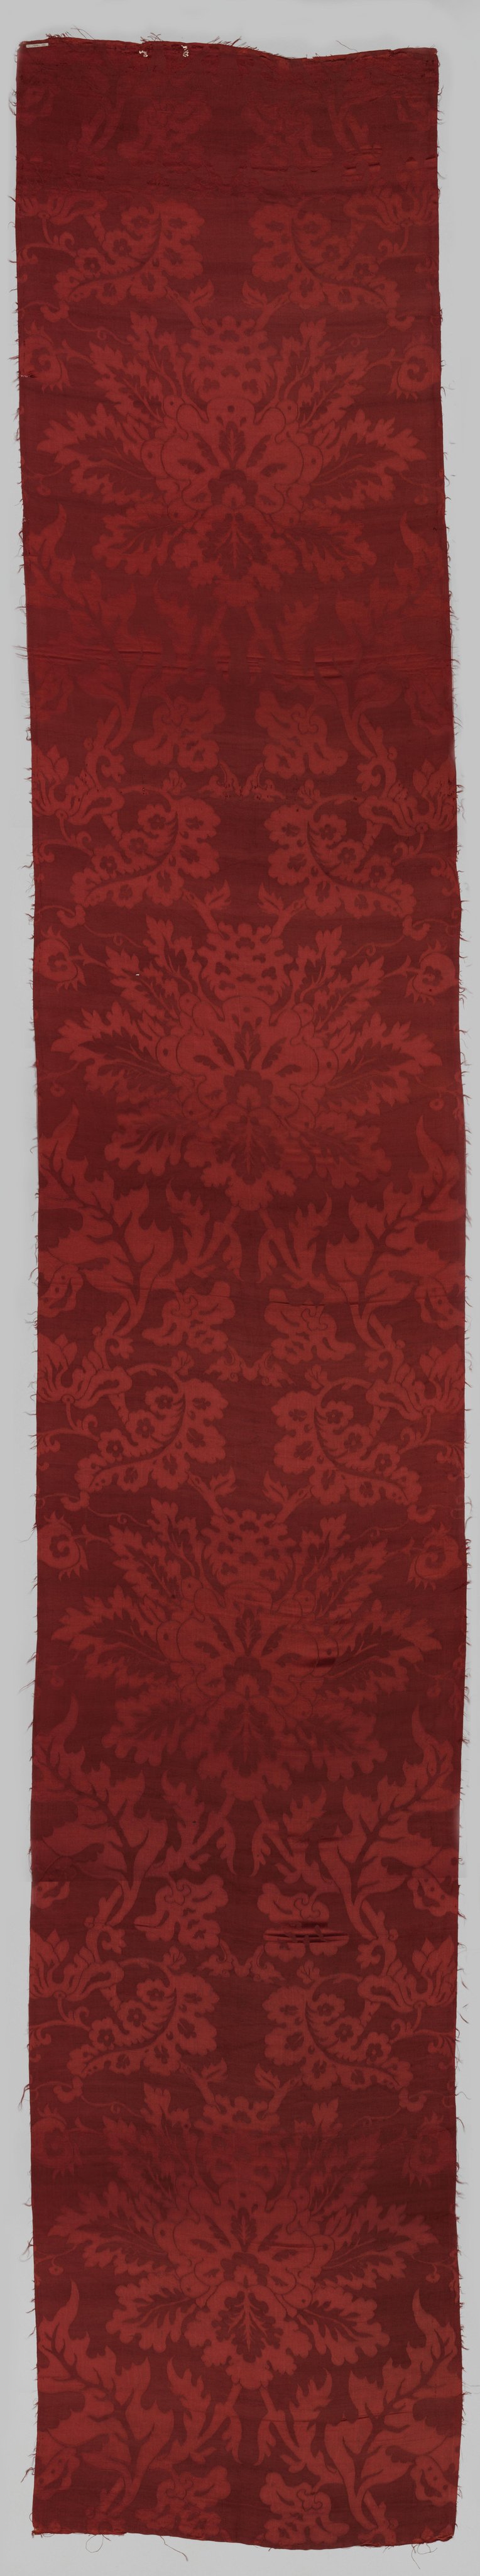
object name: fragment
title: Fragment rood zijdeweefsel; damast.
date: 1830-1870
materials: silk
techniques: damask, weave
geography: france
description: Fragment rood zijdeweefsel, met een patroon van bloem- en bladmotieven.